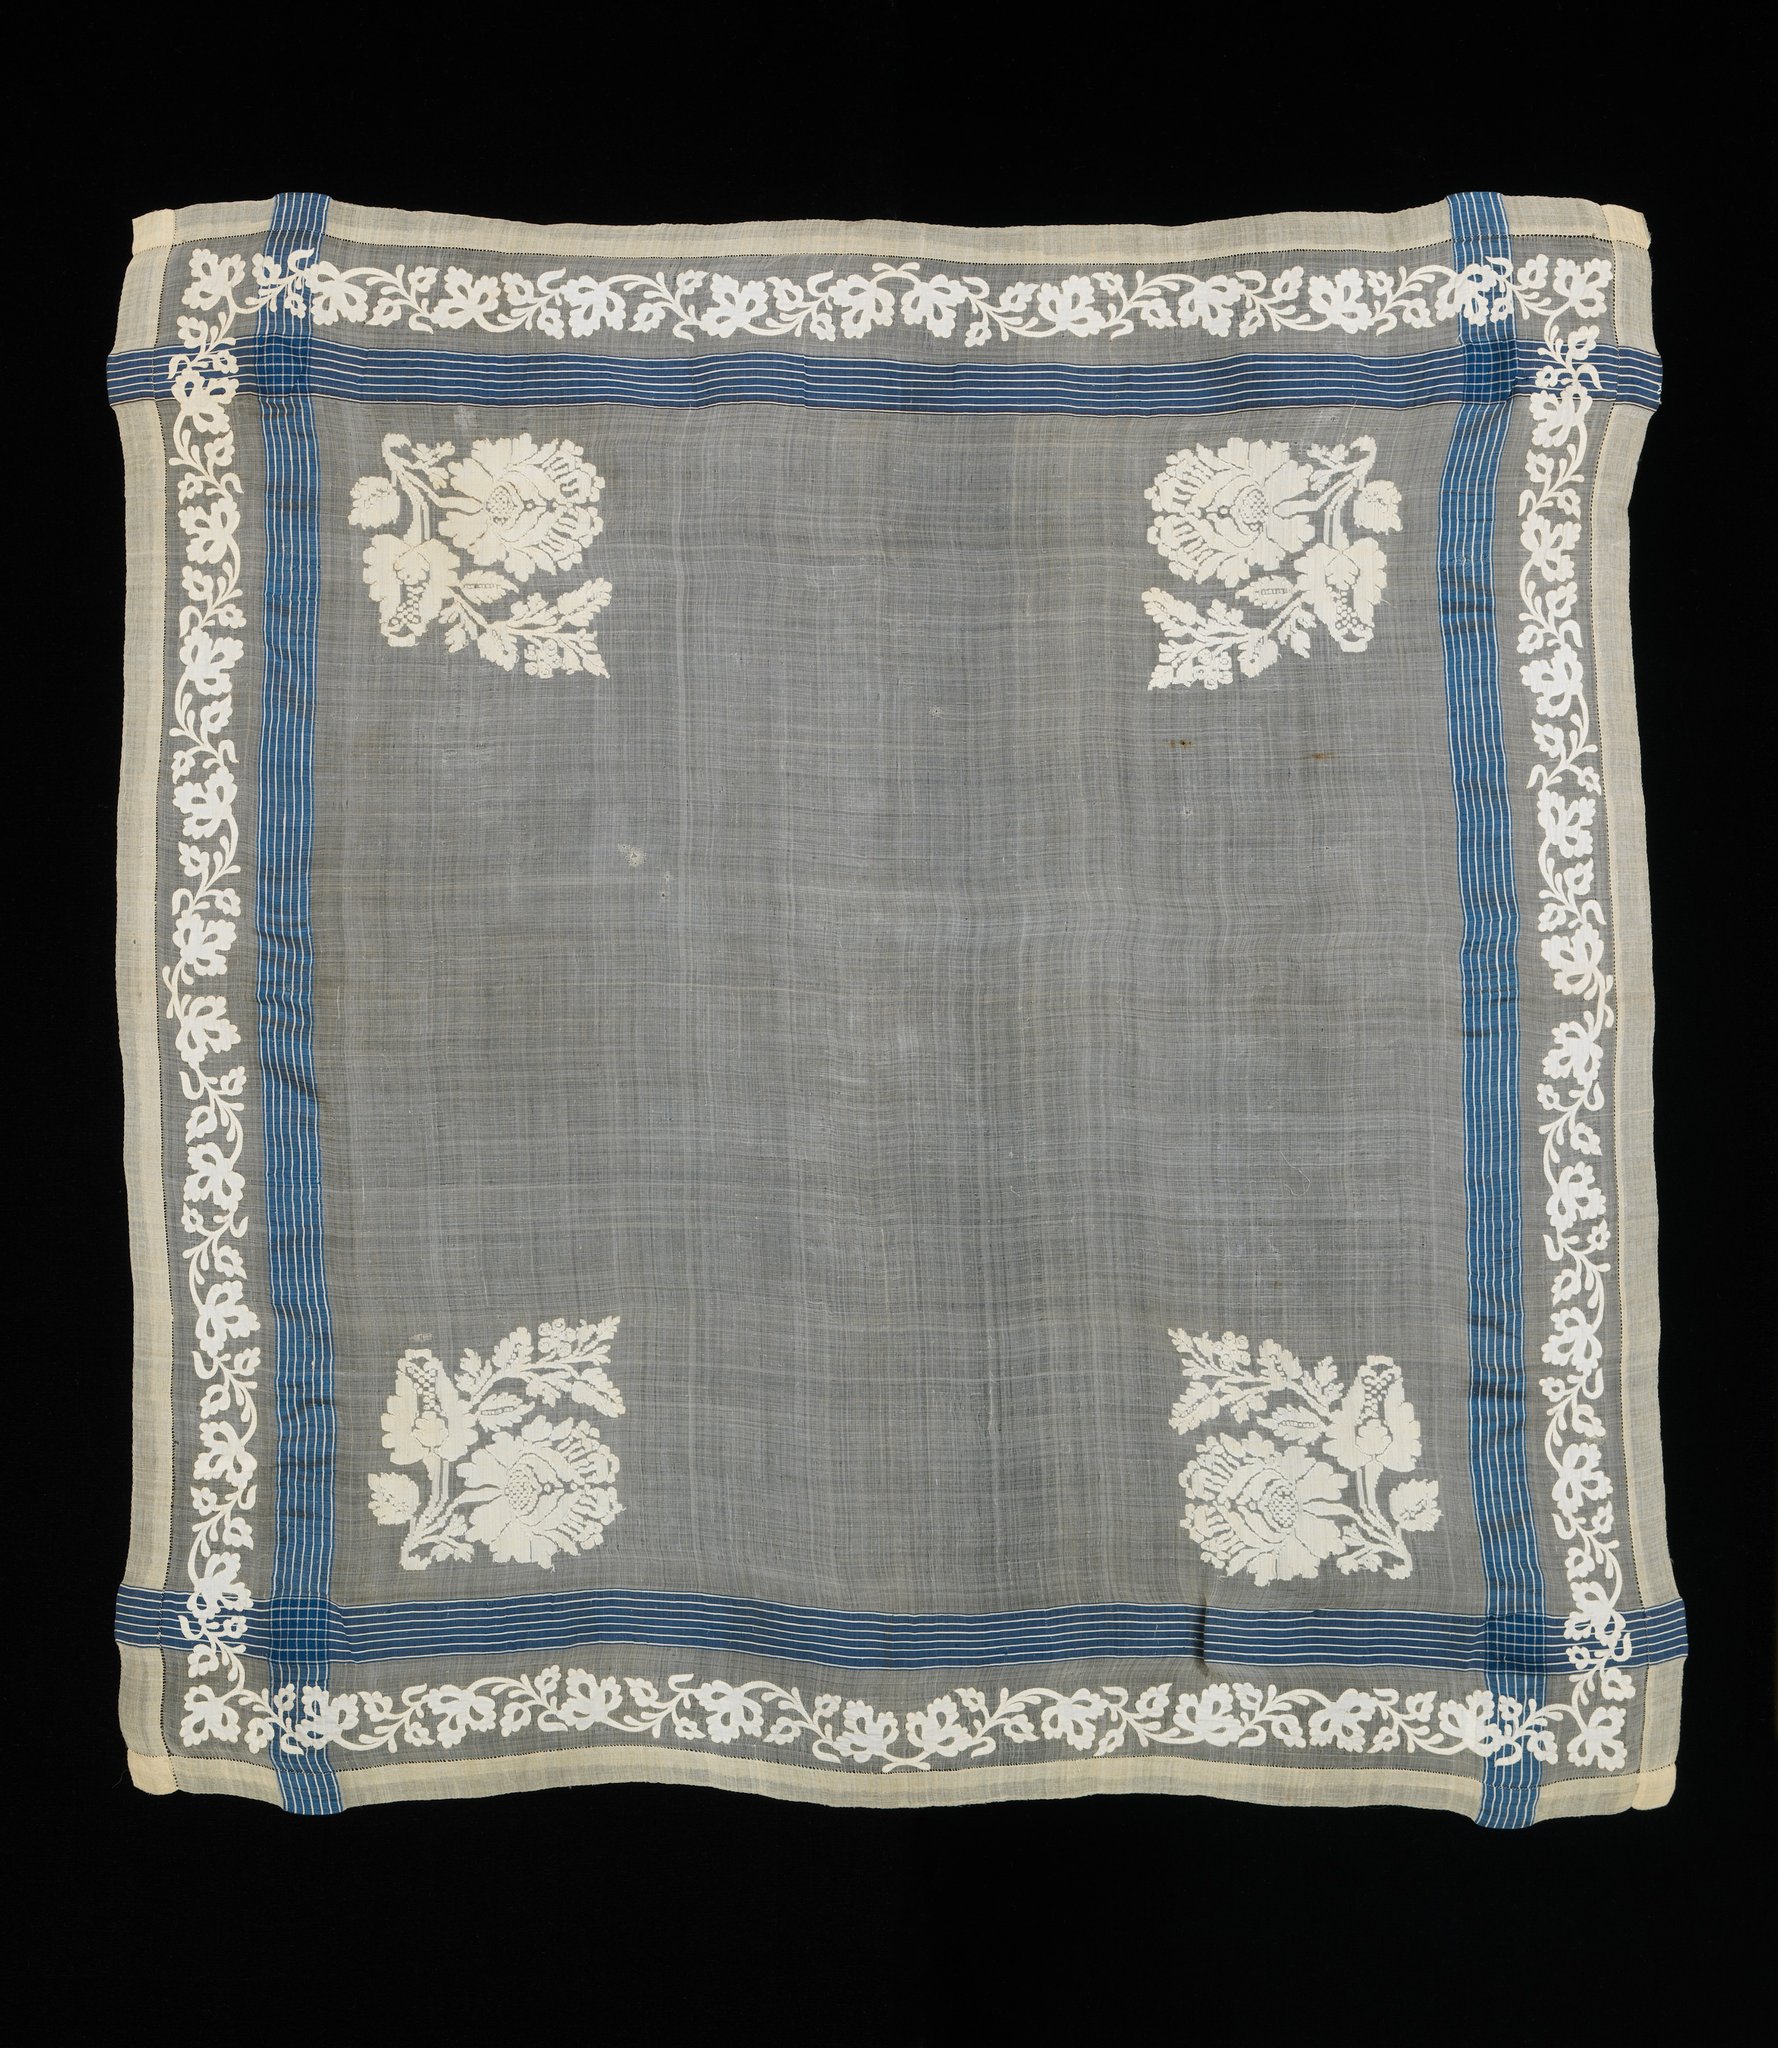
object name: handkerchief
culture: philippine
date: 1851-1875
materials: cotton